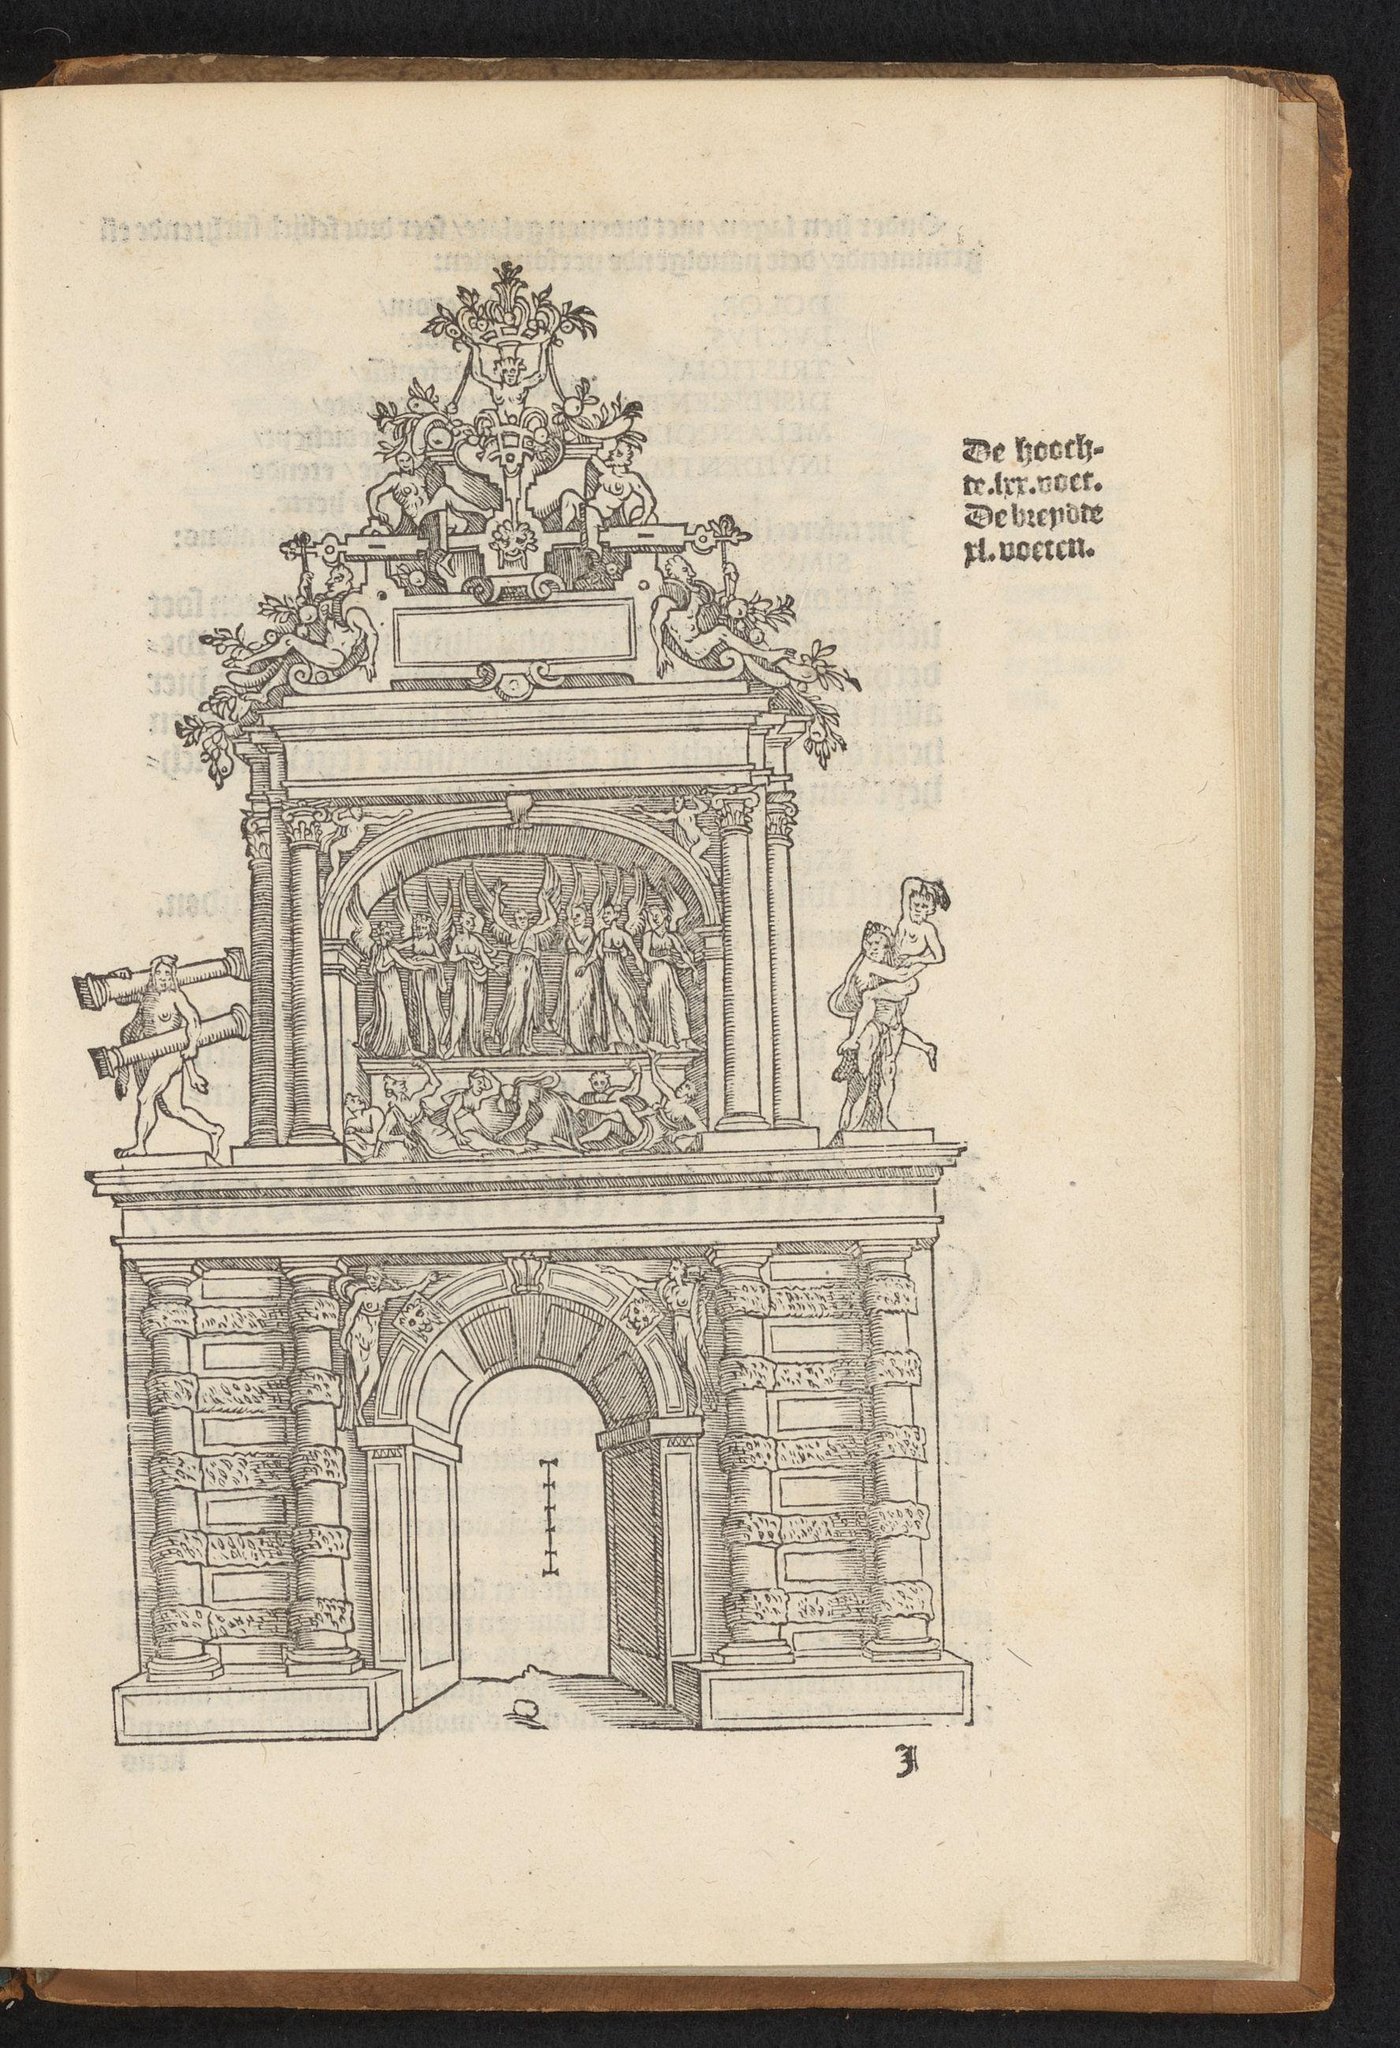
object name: print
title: Der stadt triumphael Boge aen S. Catherinen brugge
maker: pieter coecke van aelst (i)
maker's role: draughtsman, print maker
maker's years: 1502-1550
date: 1549-1550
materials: paper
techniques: woodcut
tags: philip ii of spain, 'tableau vivant', triumphal arch, antwerp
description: Illustratie in de Nederlandse vertaling van de beschrijving van de intocht van Filips II in Antwerpen in 1549: De seer wonderlijcke schoone triumphelijcke incompst, van den hooghmogenden Prince Philips, Prince van Spaignen, Caroli des vijfden, Keysers sone : inde stadt van Antwerpen, Anno 1549. Tekst van Cornelius Grapheus, waarschijnlijk vertaald uit het Latijn door Gillis van Diest, opgedragen aan Filips II, uitgegeven met keizerlijke privilege door Pieter Coecke van Aelst, gedrukt door Gillis van Diest. Boek in de bibliotheek met signatuur: 325 B 12.